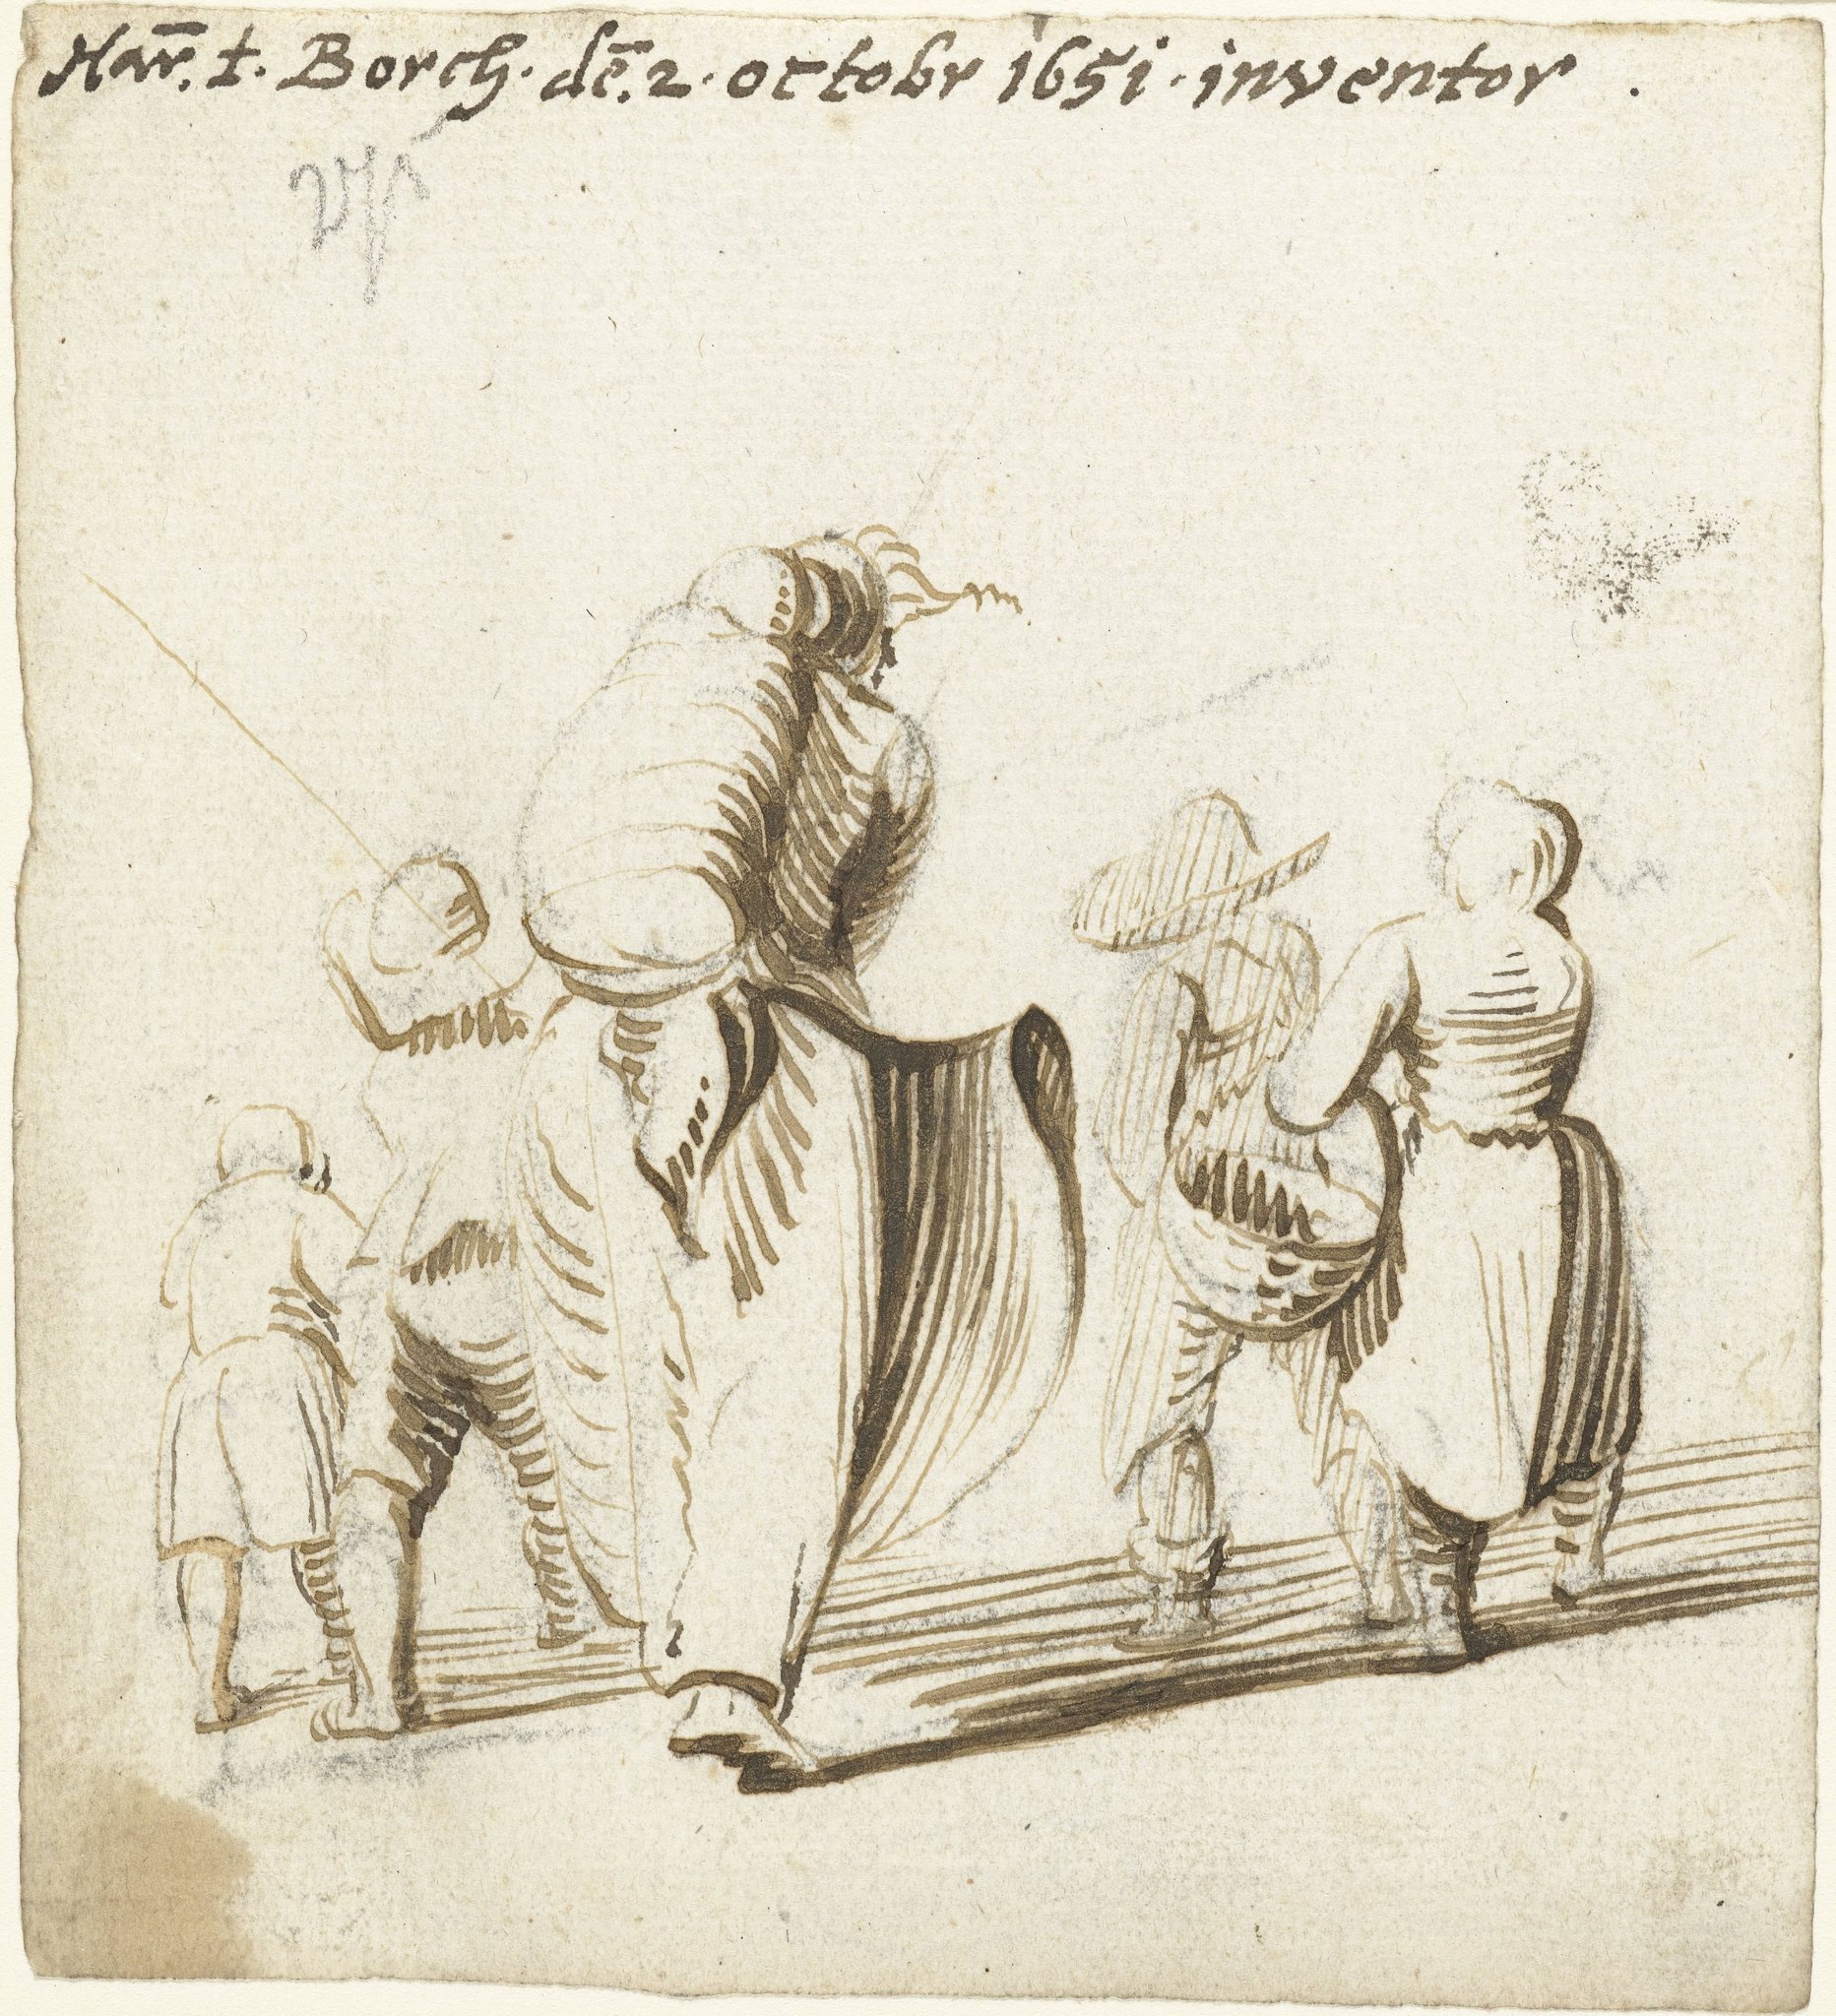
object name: drawing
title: Moeder en vijf kinderen, van achteren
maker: harmen ter borch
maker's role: draughtsman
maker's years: 1638-1677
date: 1651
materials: chalk, ink, paper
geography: zwolle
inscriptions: annotation: ‘Har[man].t.Borch. de[n].2.octobr 1651. inventor’